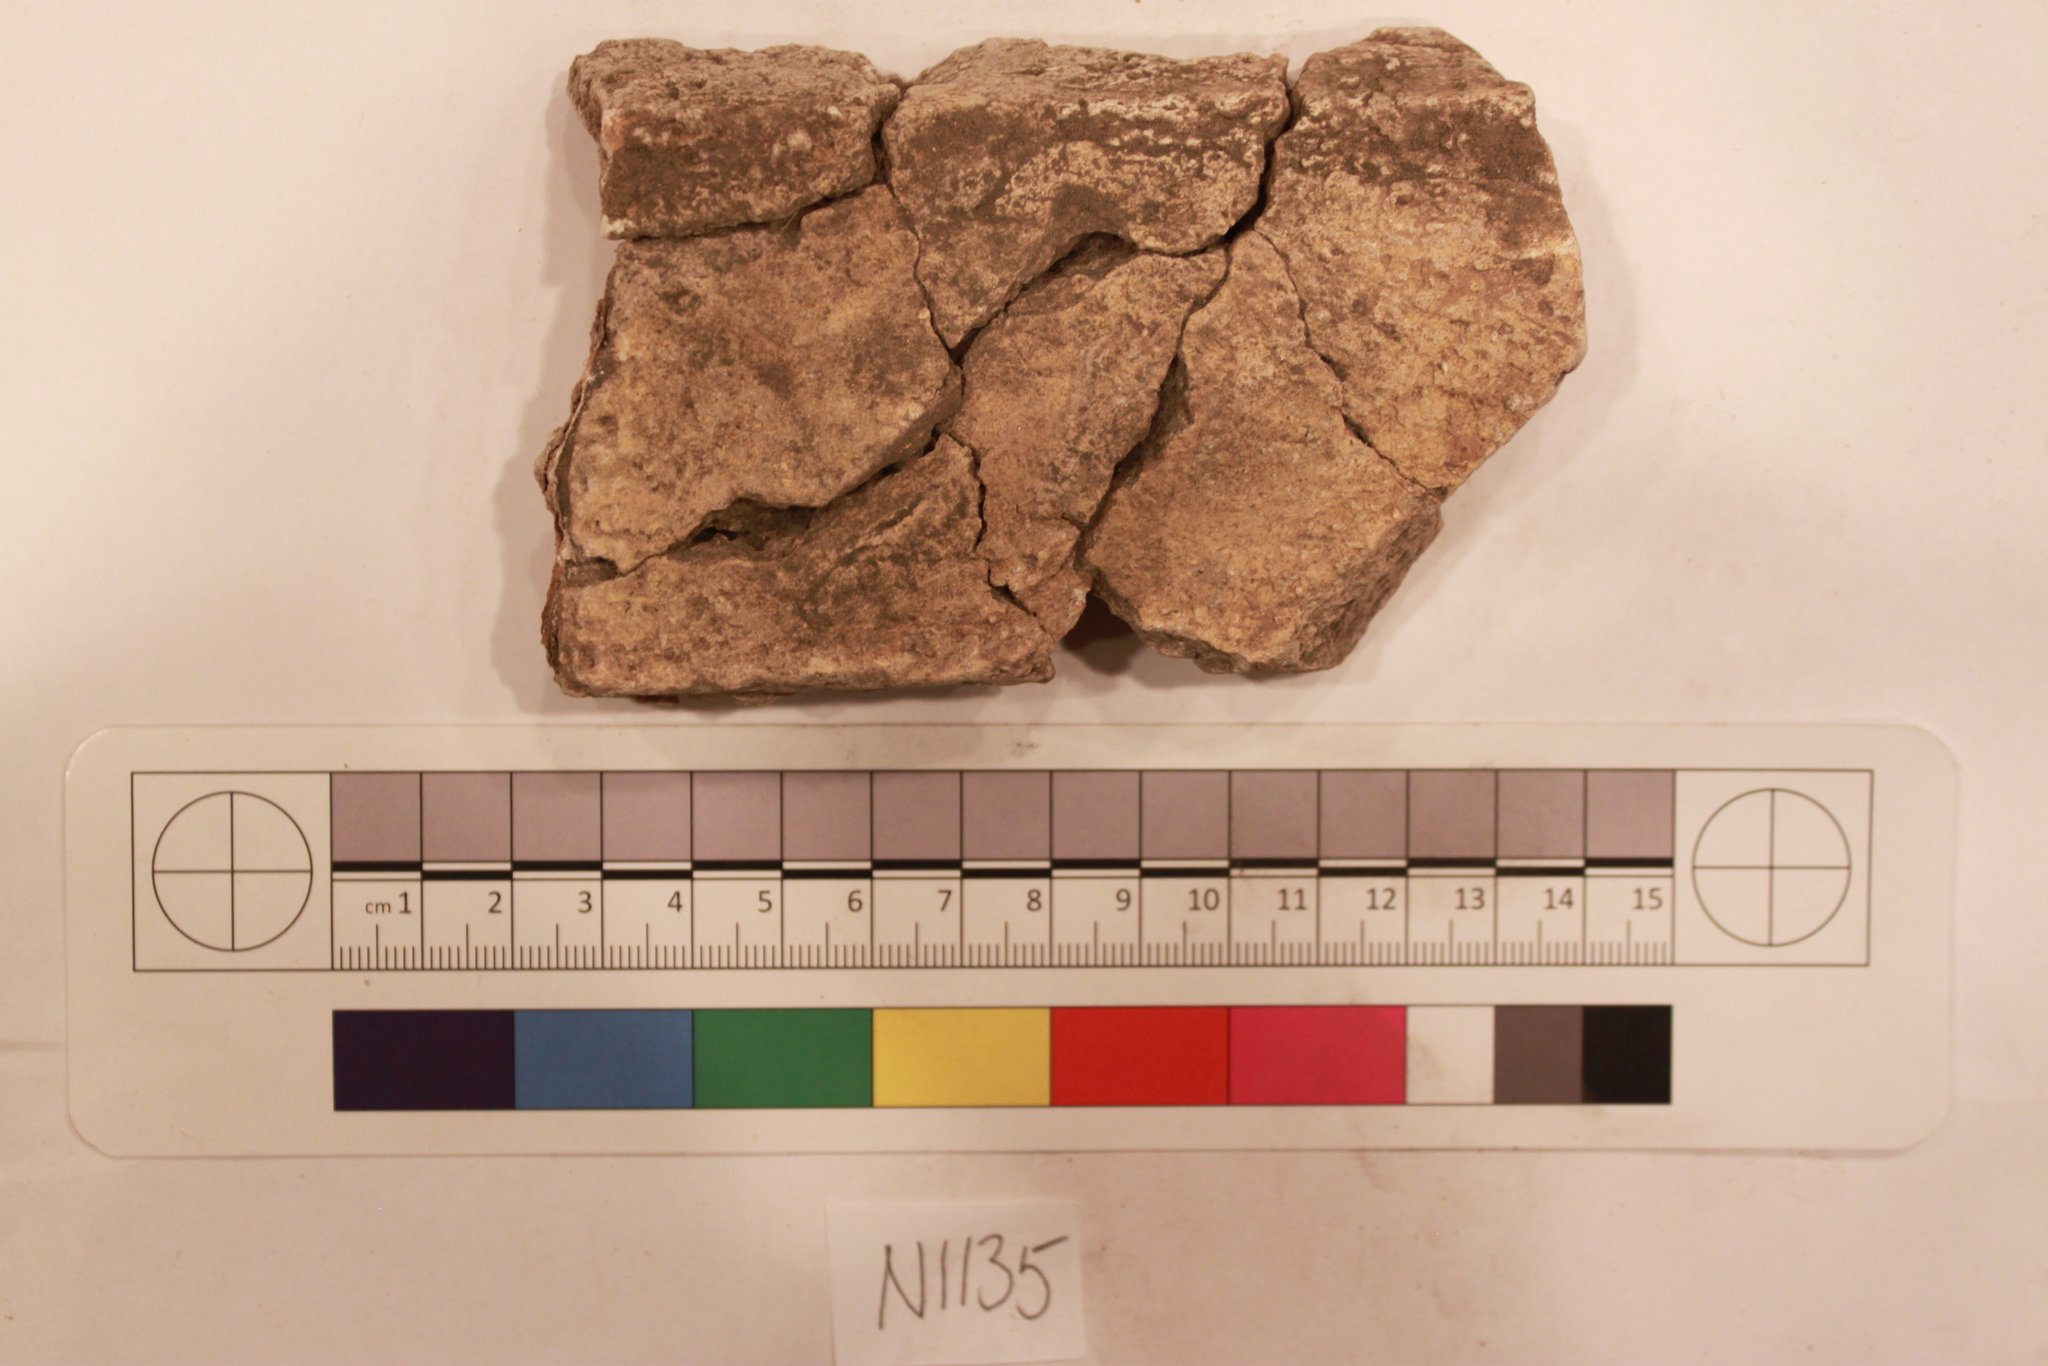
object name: fragment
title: Stucco Fragment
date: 701-1200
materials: plaster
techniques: carving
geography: iran